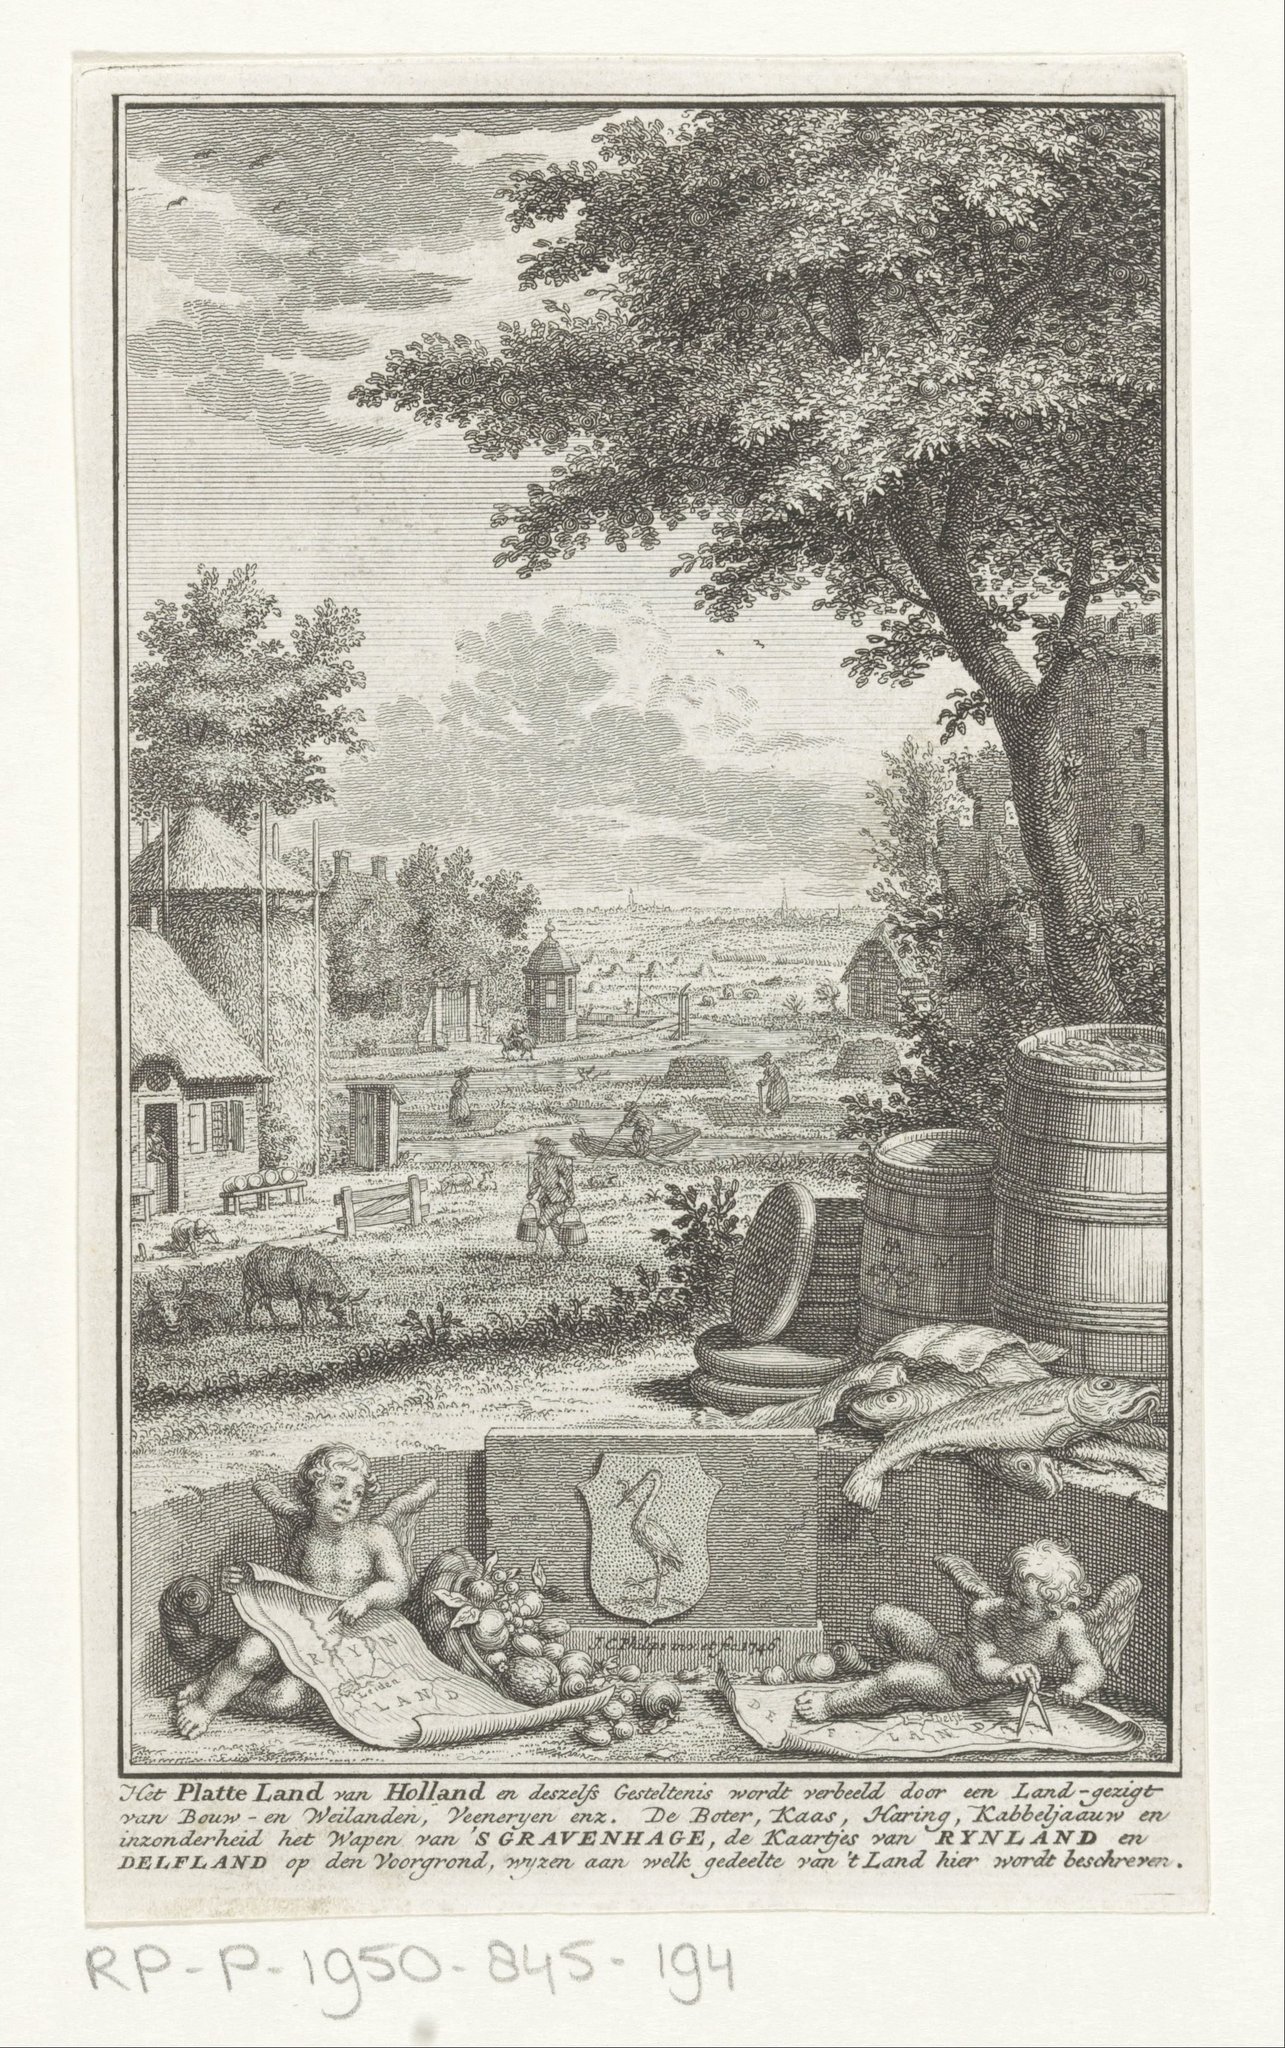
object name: print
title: Titelpagina voor: Thomas Salmon en Jan Wagenaar, Tegenwoordige staat der Vereenigde Nederlanden, Zesde deel, 1746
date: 1746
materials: paper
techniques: engraving, etching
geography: amsterdam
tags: coat of arms (as symbol of the state, etc.), landscapes, maps, atlases, delft, holland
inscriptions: collector's mark: Lugt 2228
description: Titelpagina voor: Salmon, Thomas en Wagenaar, Jan. Tegenwoordige staat der Vereenigde Nederlanden, Zesde deel. Amsterdam: Tirion, Isaak, 1746. / Titelpagina voor: Salmon, Thomas. Hedendaagsche historie of tegenwoordige staat van alle volkeren, XVIde deel. Amsterdam: Tirion, Isaak, 1746. Tussen 1739 en 1804 verscheen bij de Amsterdamse uitgever Isaak Tirion een serie van 23 delen ‘Tegenwoordige staat der Vereenigde Nederlanden’, een verzamelwerk voor een groot deel van de hand van Jan Wagenaar. Deze 23 delen waren een onderdeel van een veel groter werk, de ‘Hedendaagsche historie of tegenwoordige staat van alle volkeren’, waarvan het eerste deel in 1729 was verschenen. Beide series hebben een eigen nummering: de delen 1 t/m 23 van de serie over de Vereenigde Nederlanden zijn genummerd 11 t/m 33 van de Tegenwoordige staat van alle volkeren. Prent afkomstig uit een plakalbum met titelprenten, ornamenten etc. op blauw papier in 1983 uit elkaar gehaald. Volgens een notitie op verso zat de prent op p. 194 van dit album.